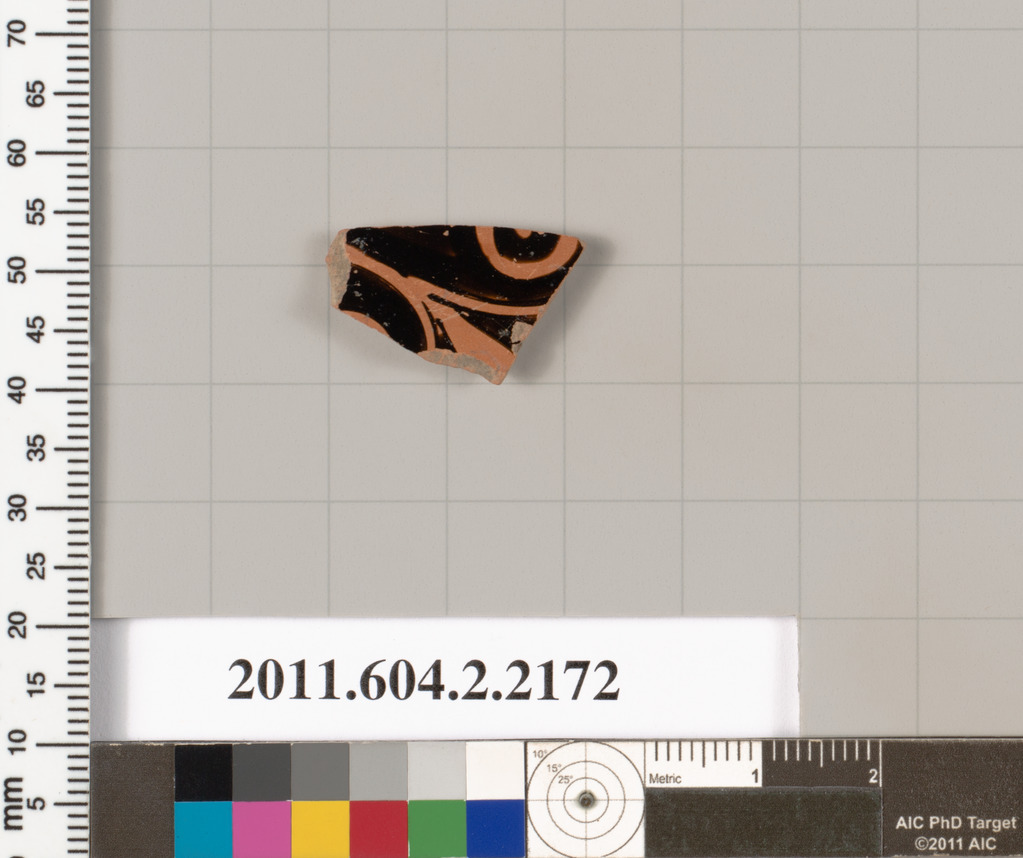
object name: pot fragment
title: Terracotta fragment of a pot; unglazed on the inside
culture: greek, attic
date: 475-451 BCE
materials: terracotta